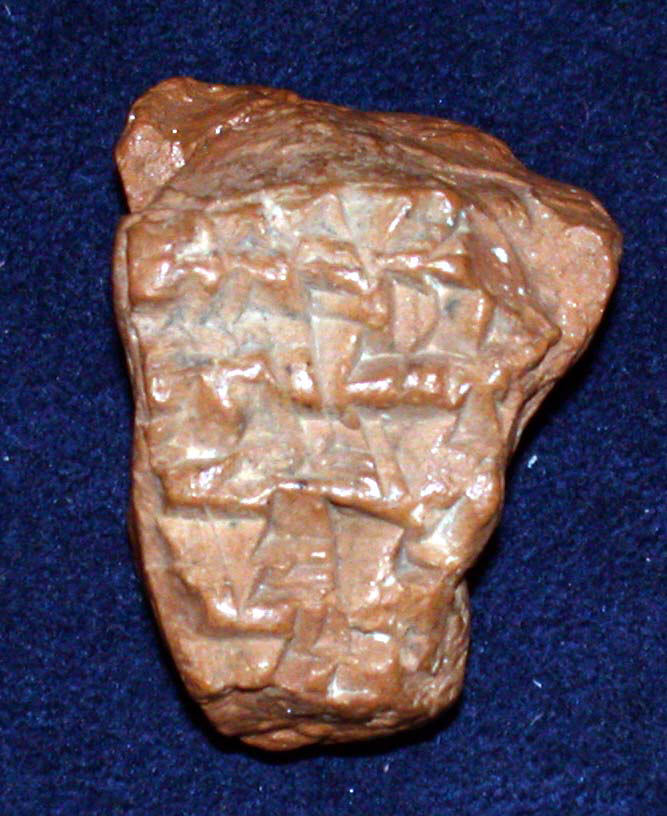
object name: cuneiform tablet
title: Cuneiform tablet: unidentified fragment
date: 333-1 BCE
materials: clay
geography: mesopotamia